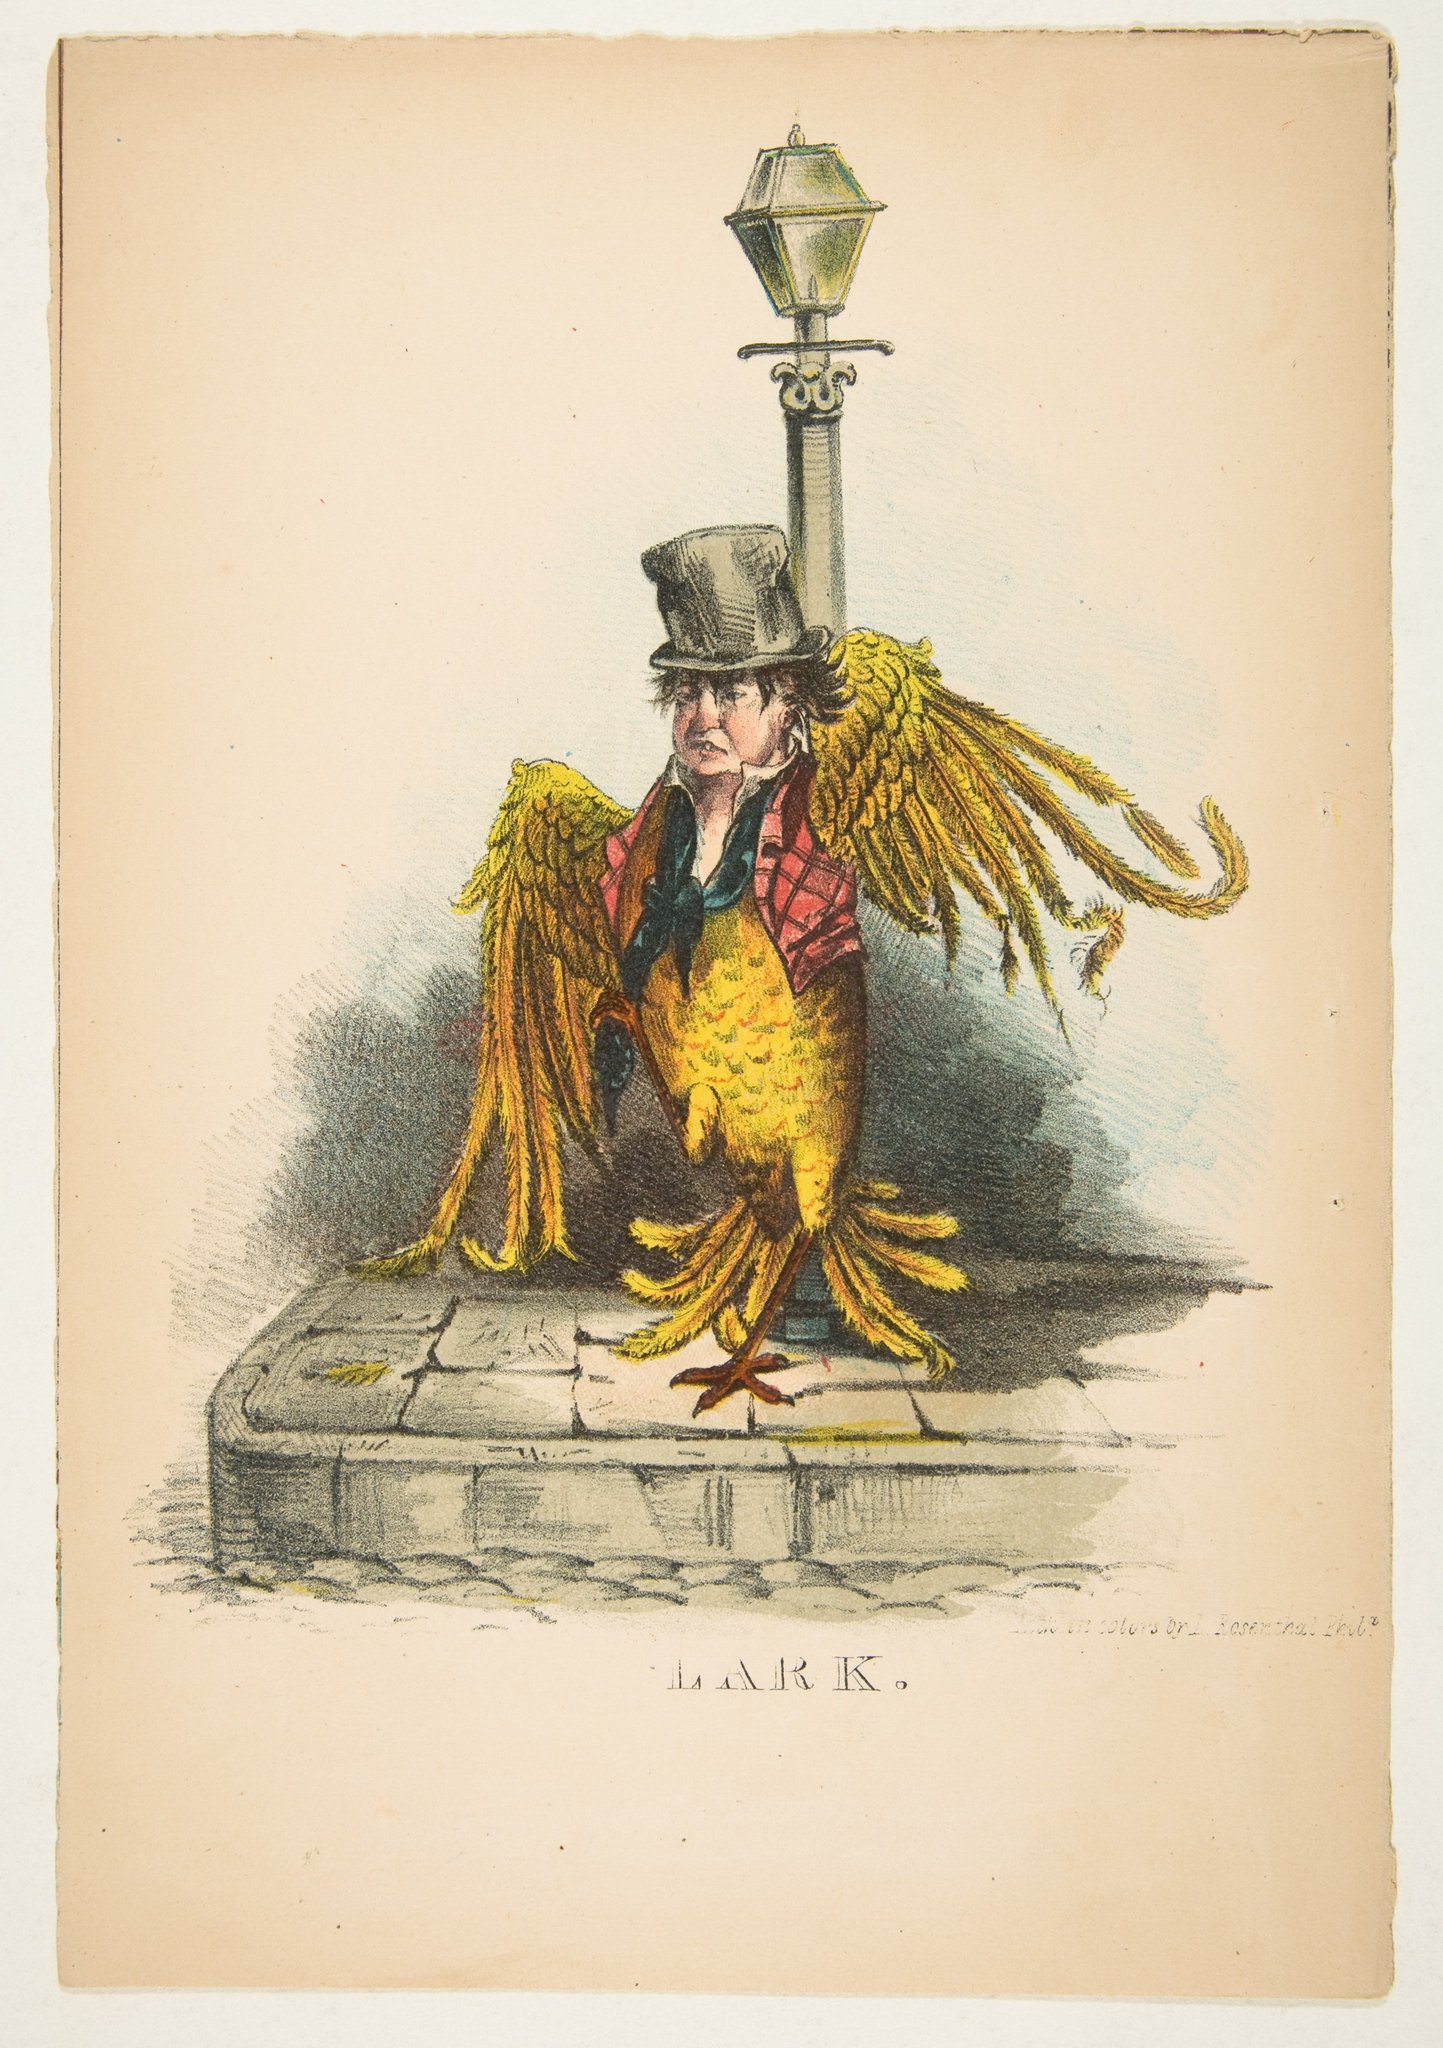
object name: print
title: Lark, from "The Comic Natural History of the Human Race"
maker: henry louis stephens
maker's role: artist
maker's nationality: american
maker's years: 1824-1882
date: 1851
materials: watercolor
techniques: lithograph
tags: satire